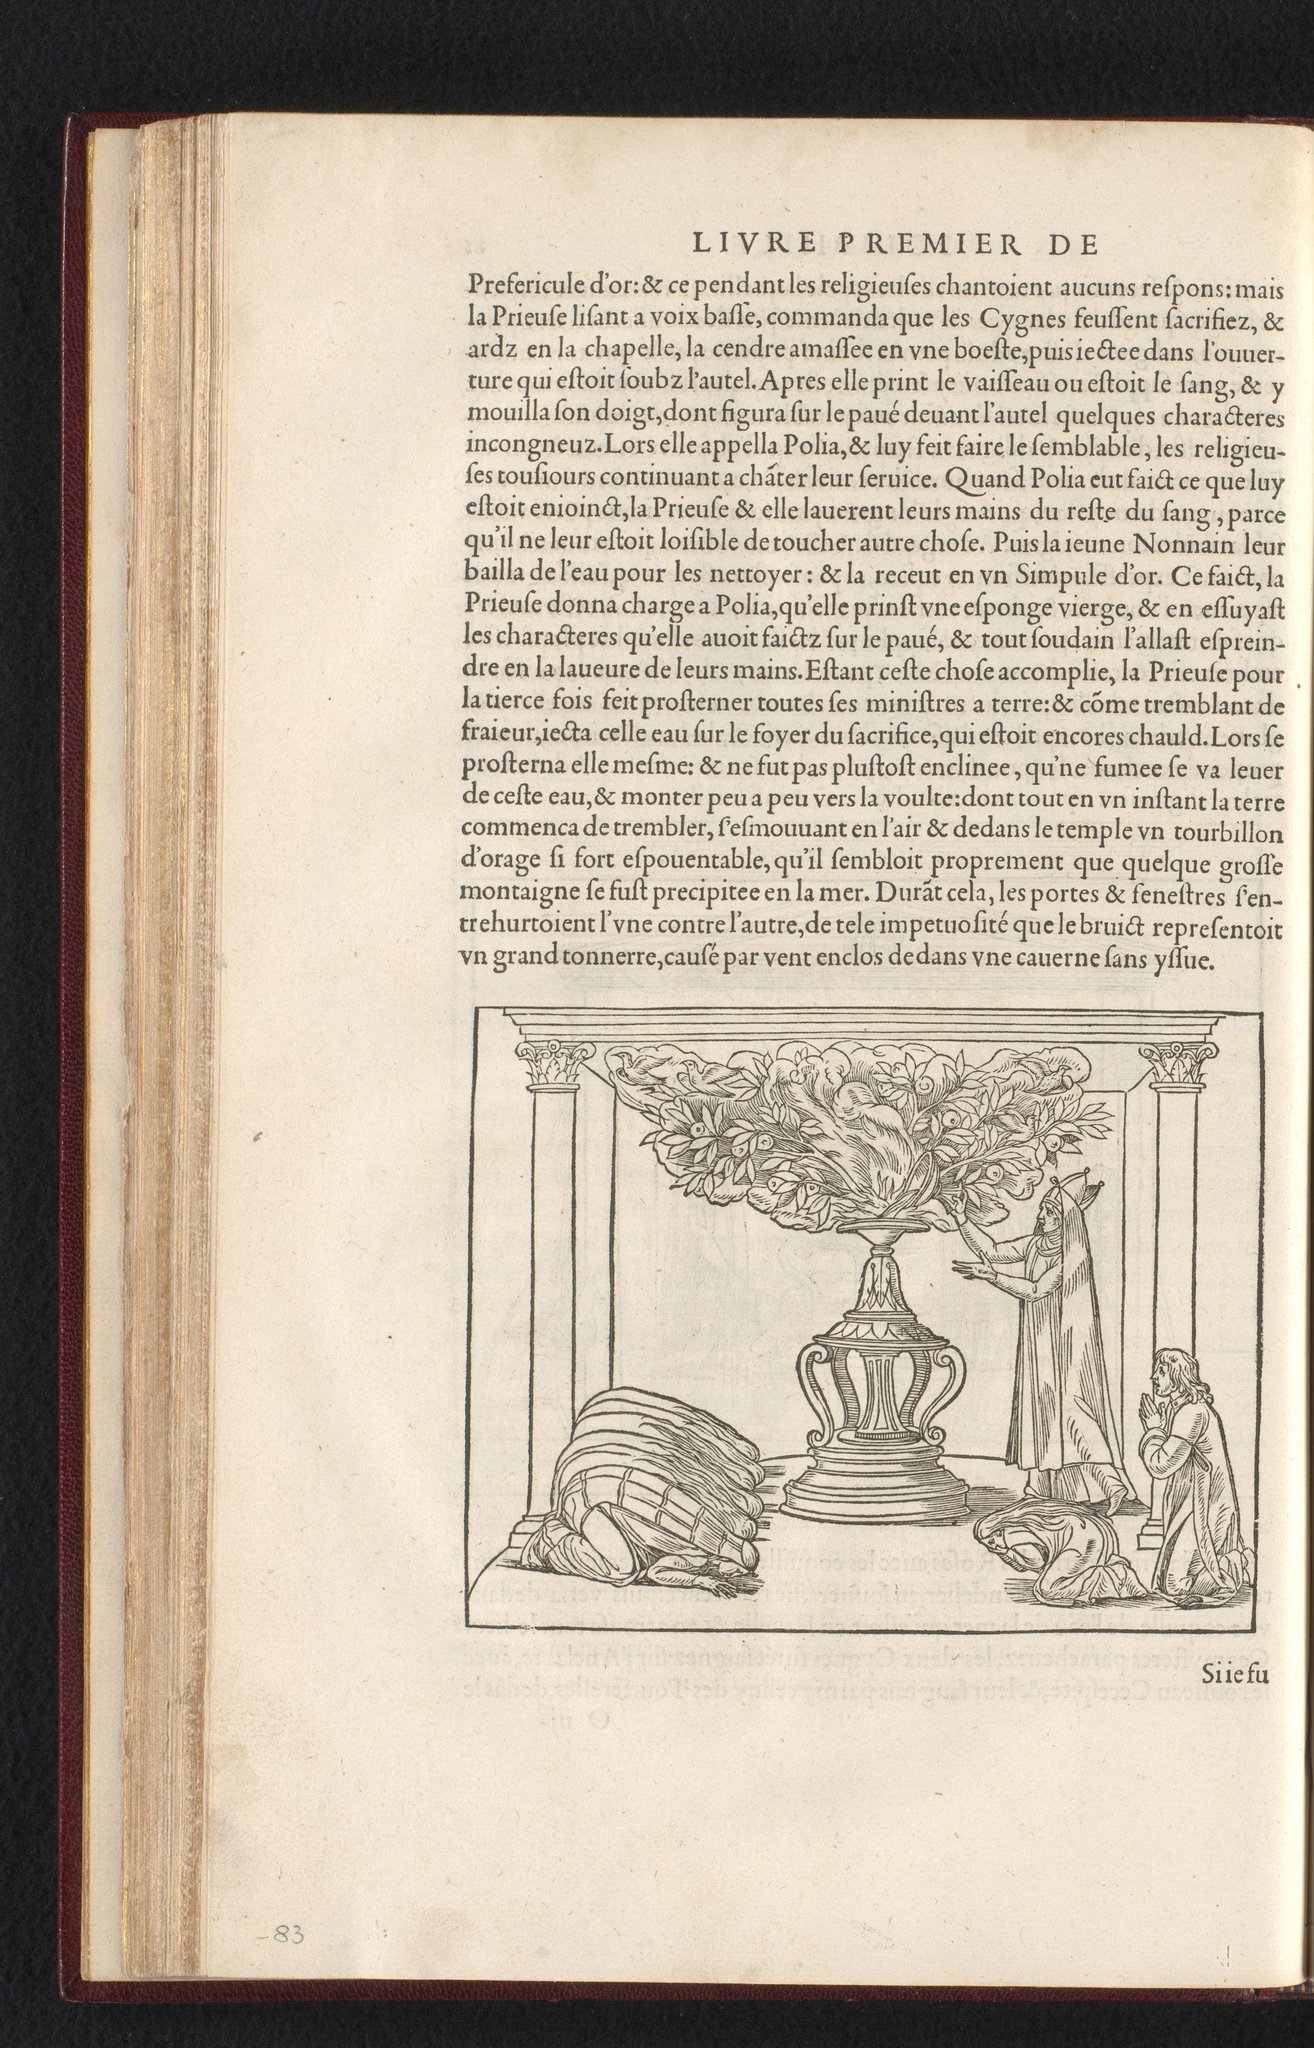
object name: page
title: In rook groeit een plant in het altaar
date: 1546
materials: paper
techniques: letterpress printing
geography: paris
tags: altar ~ non-christian religions, priest ~ greek religion - ee - priestess, (scenes from) specific works of literature: colonna, hypnerotomachia poliphili, prostration, 'proskynesis'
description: Prent uit: Colonna, Francesco. Hypnerotomachie ou discours du songe de Poliphile, deduisant comme amour le combat a l'occasion de Polia. Parijs: Jacques Kerver, 1546, verso fol. 81.